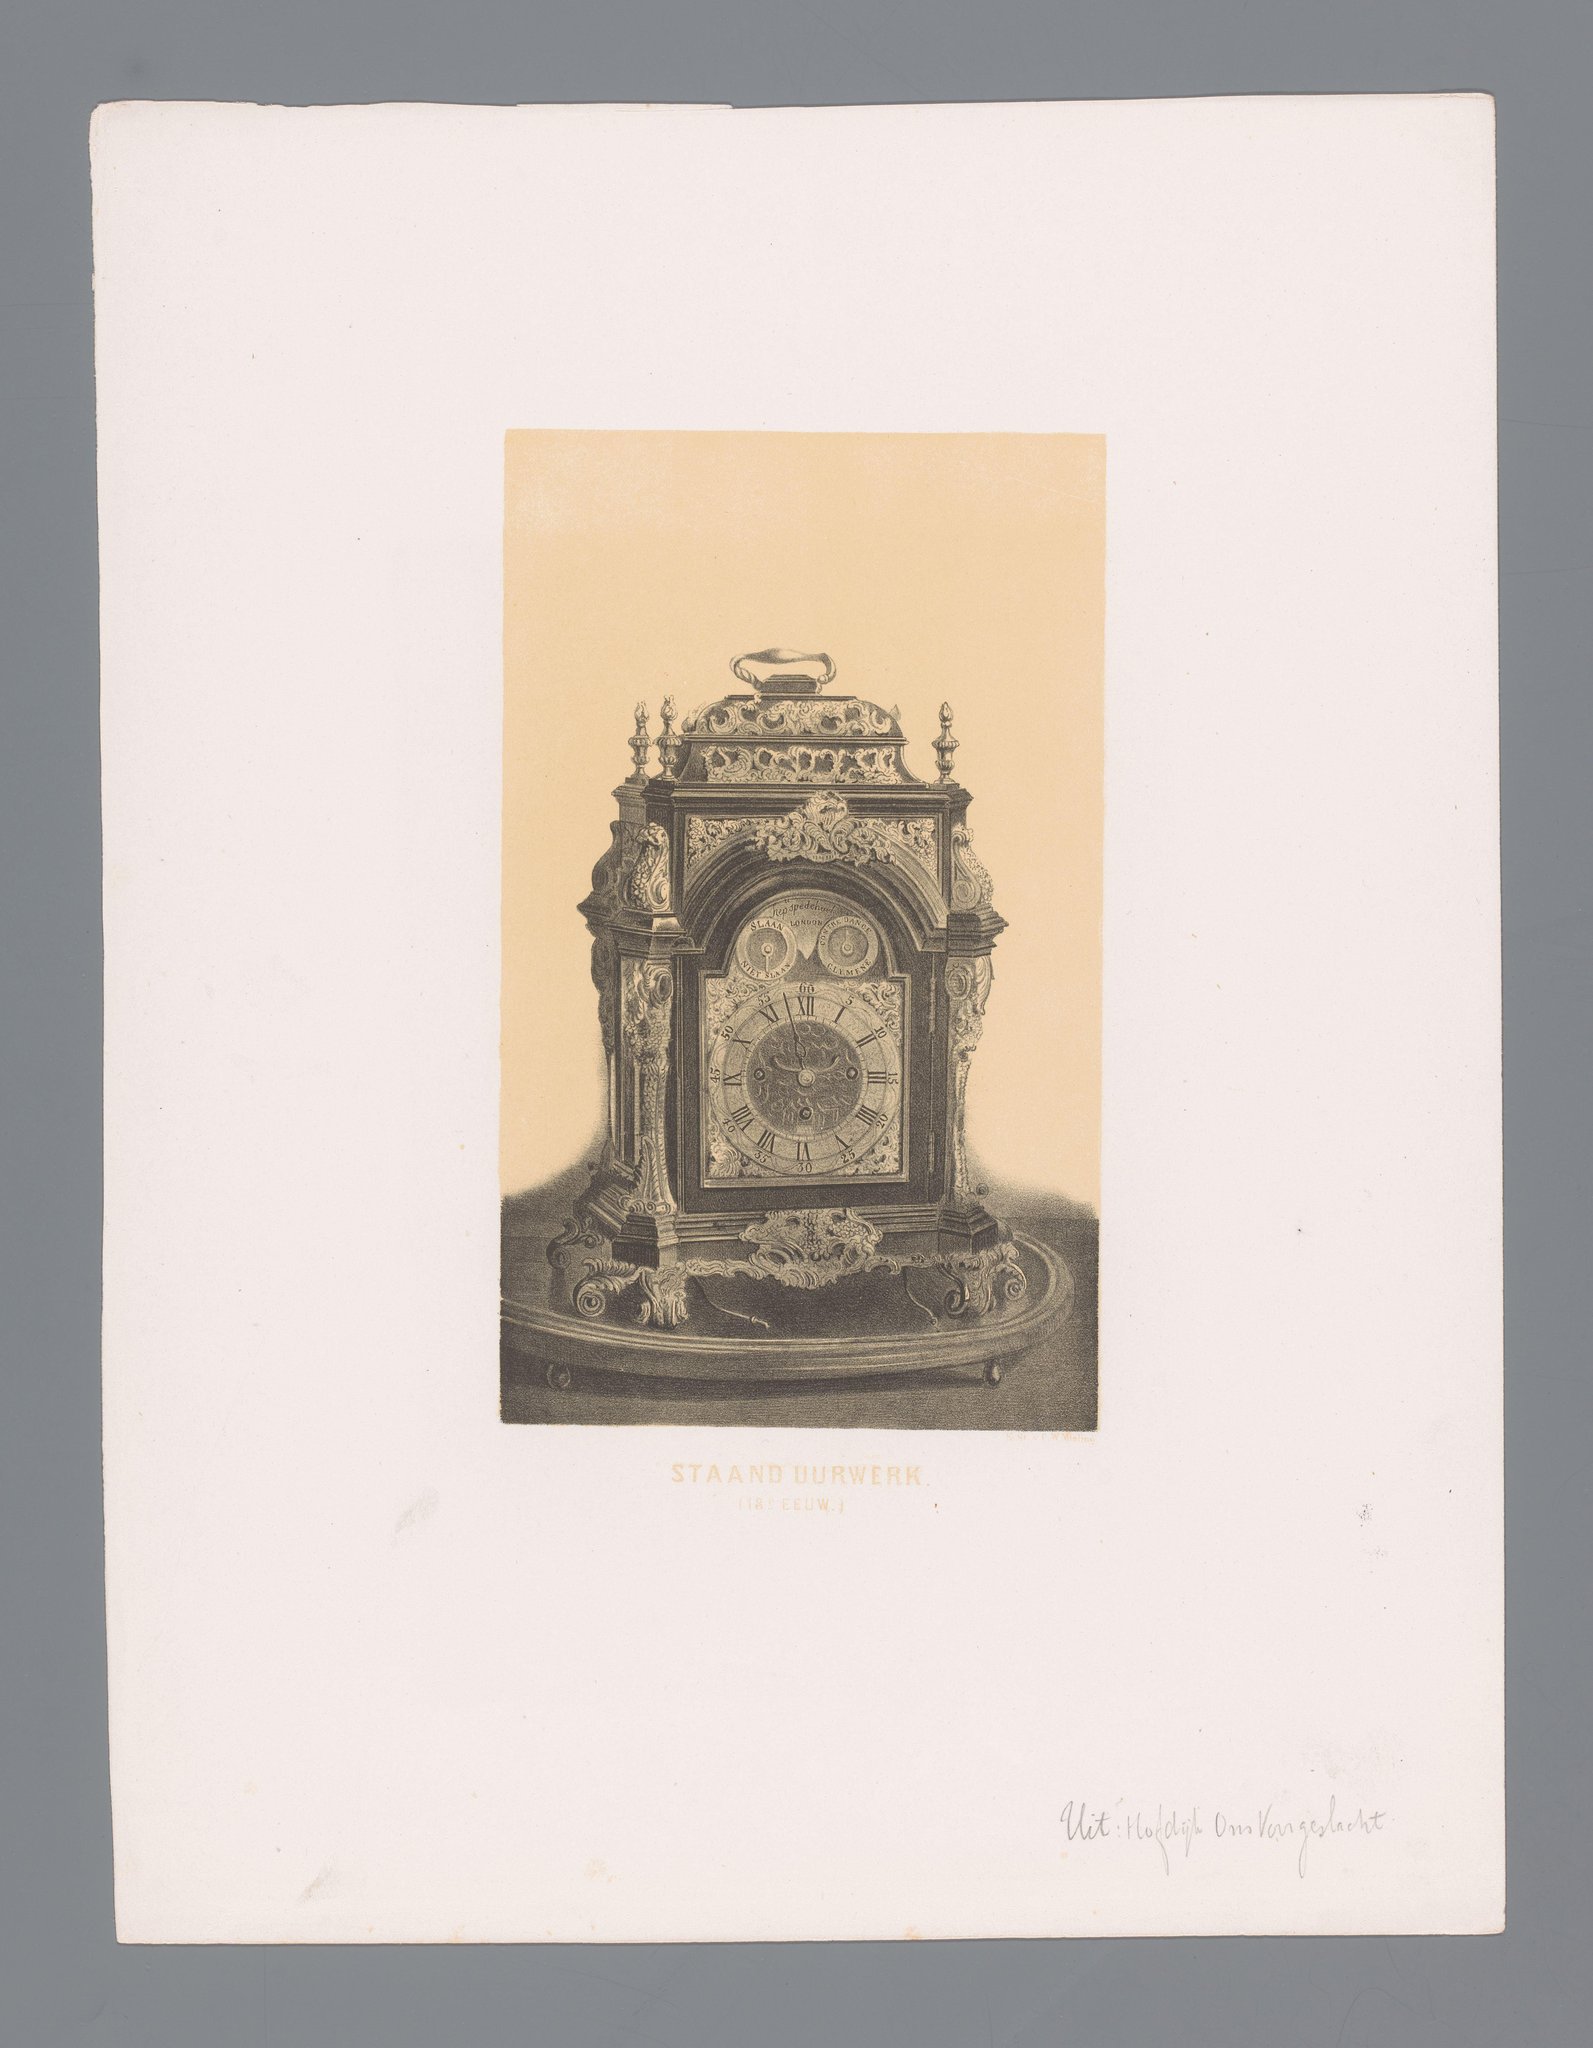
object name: print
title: Staand uurwerk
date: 1864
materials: paper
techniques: tone lithography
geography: haarlem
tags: clock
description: De klokt komt uit de achttiende eeuw en is versierd met bladmotieven.